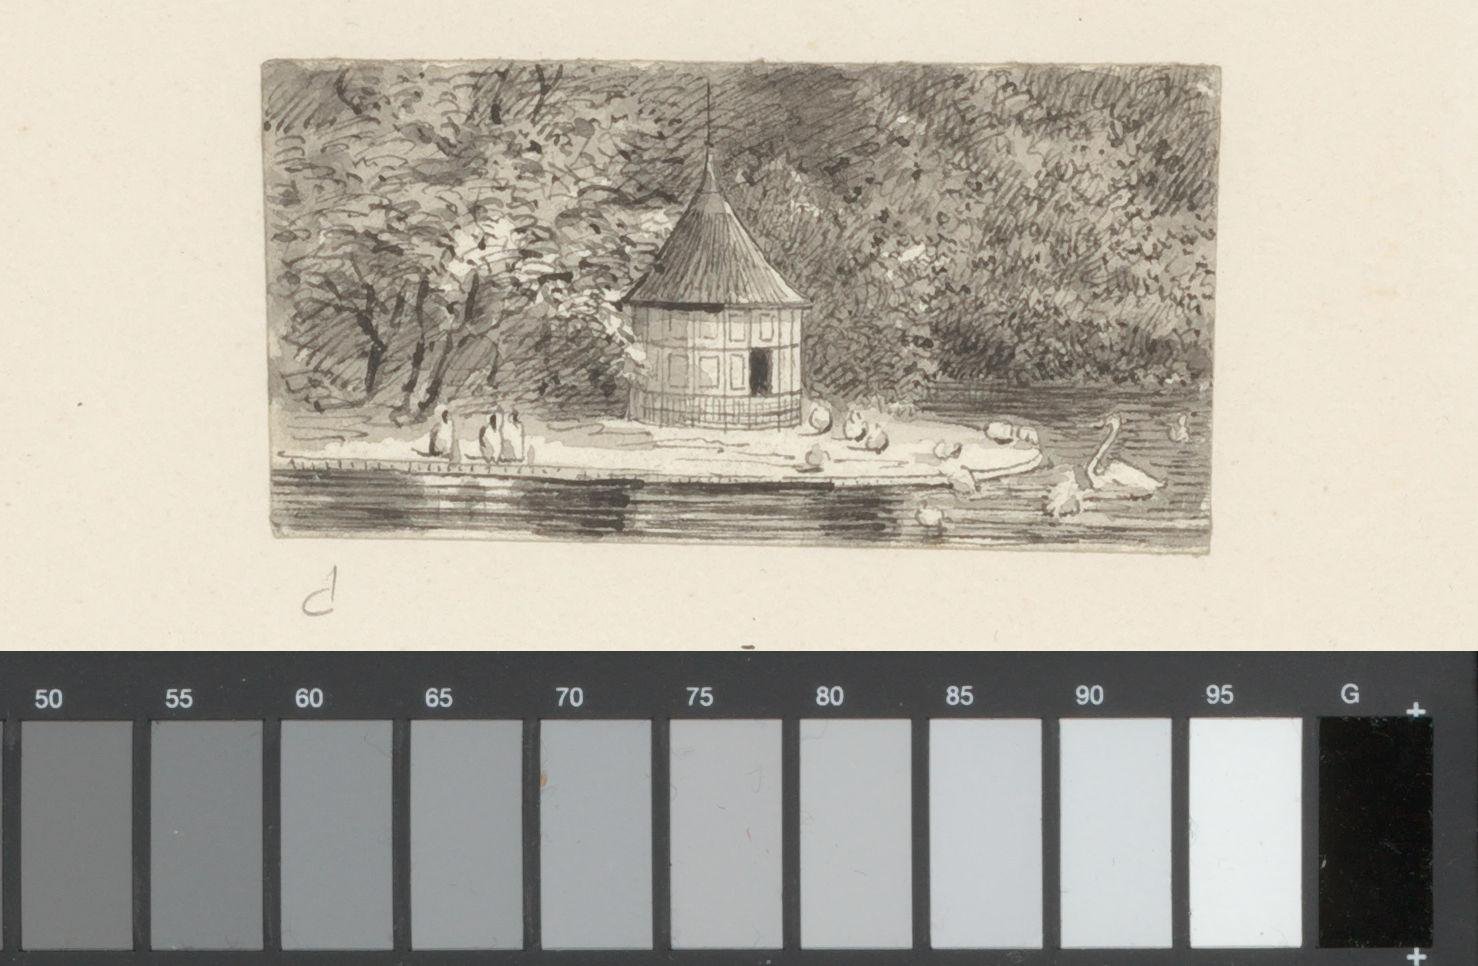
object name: drawing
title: Gezicht op het verblijf van de vogels in Artis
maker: friedrich wilhelm wittig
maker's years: 1854-1912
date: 1880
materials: ink, paper, pencil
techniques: brush, pen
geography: amsterdam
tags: city-view in general; 'veduta', zoo (as place of recreation)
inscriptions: inscription: ‘zie het boek (...) 22 N. 689’, inscription: ‘Fr. Wittig / Erinnerungen (...) No 462 / 1088’, name: ‘In Artis Natura Magistra. / F. Wittig fecit.’, inscription: ‘Legaat Joh. M. Coffeng / 1966’, collector's mark: ‘51B / VDE 8.12.'86’, number: ‘76’